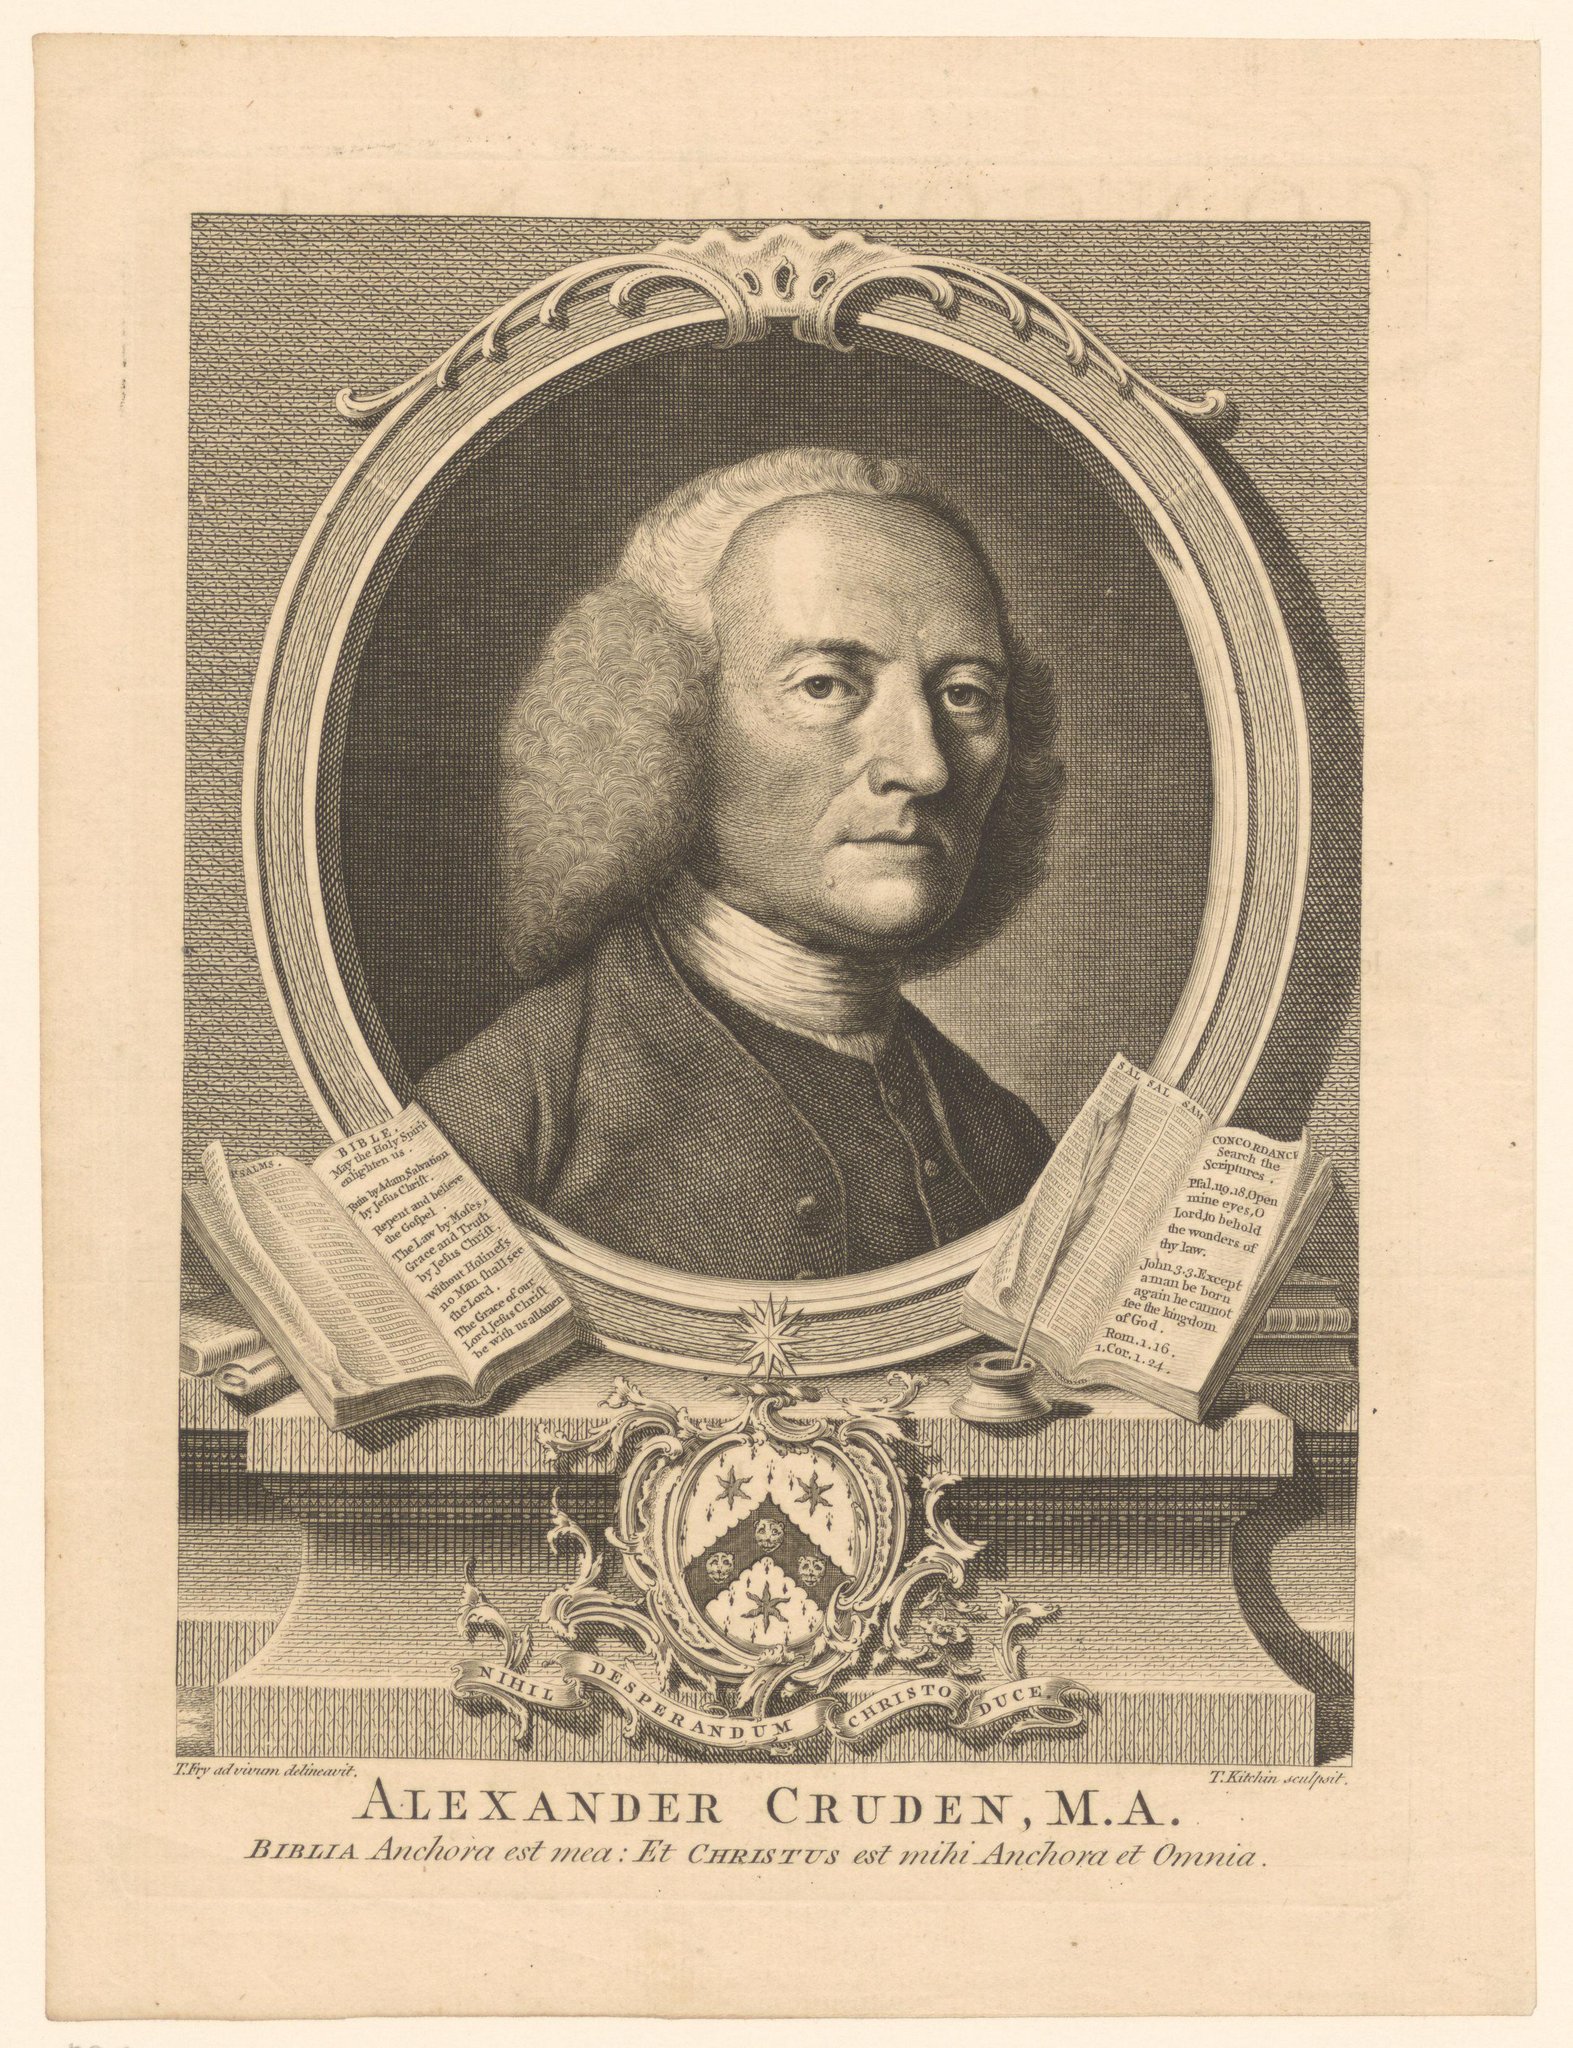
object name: print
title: Portret van Alexander Cruden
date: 1729-1784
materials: paper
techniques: engraving, etching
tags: theologian, historical persons, merchant, salesman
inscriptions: collector's mark: Lugt 2228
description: Tekst in het Engels in de boeken en in het Latijn in de ondermarge.